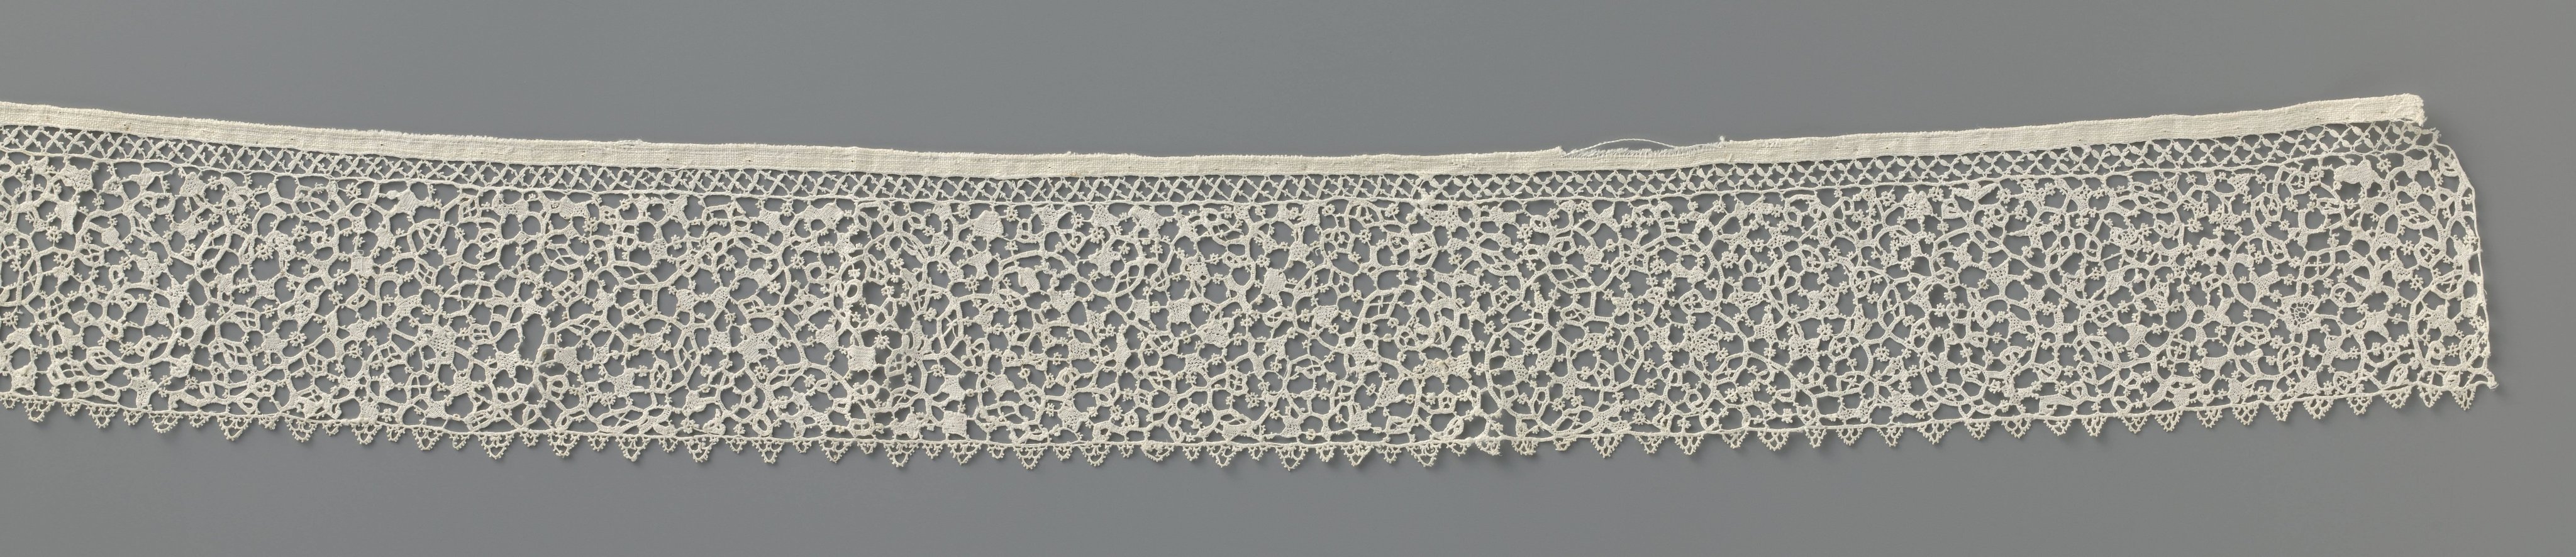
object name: strip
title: Strook naaldkant met serpentines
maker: Anonymous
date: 1690-1699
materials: linen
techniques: flat venetian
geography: venice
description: Strook naturelkleurige naaldkant: platte Venetiaanse kant. Onregelmatige open spijlengrond van korte, met radertjes-picots bezette spijltjes. Dunne elkaar kruisende spiraalrankjes vormen een lopend patroon van serpentines. Rechte buitenlijst van gelijke driehoekjes.